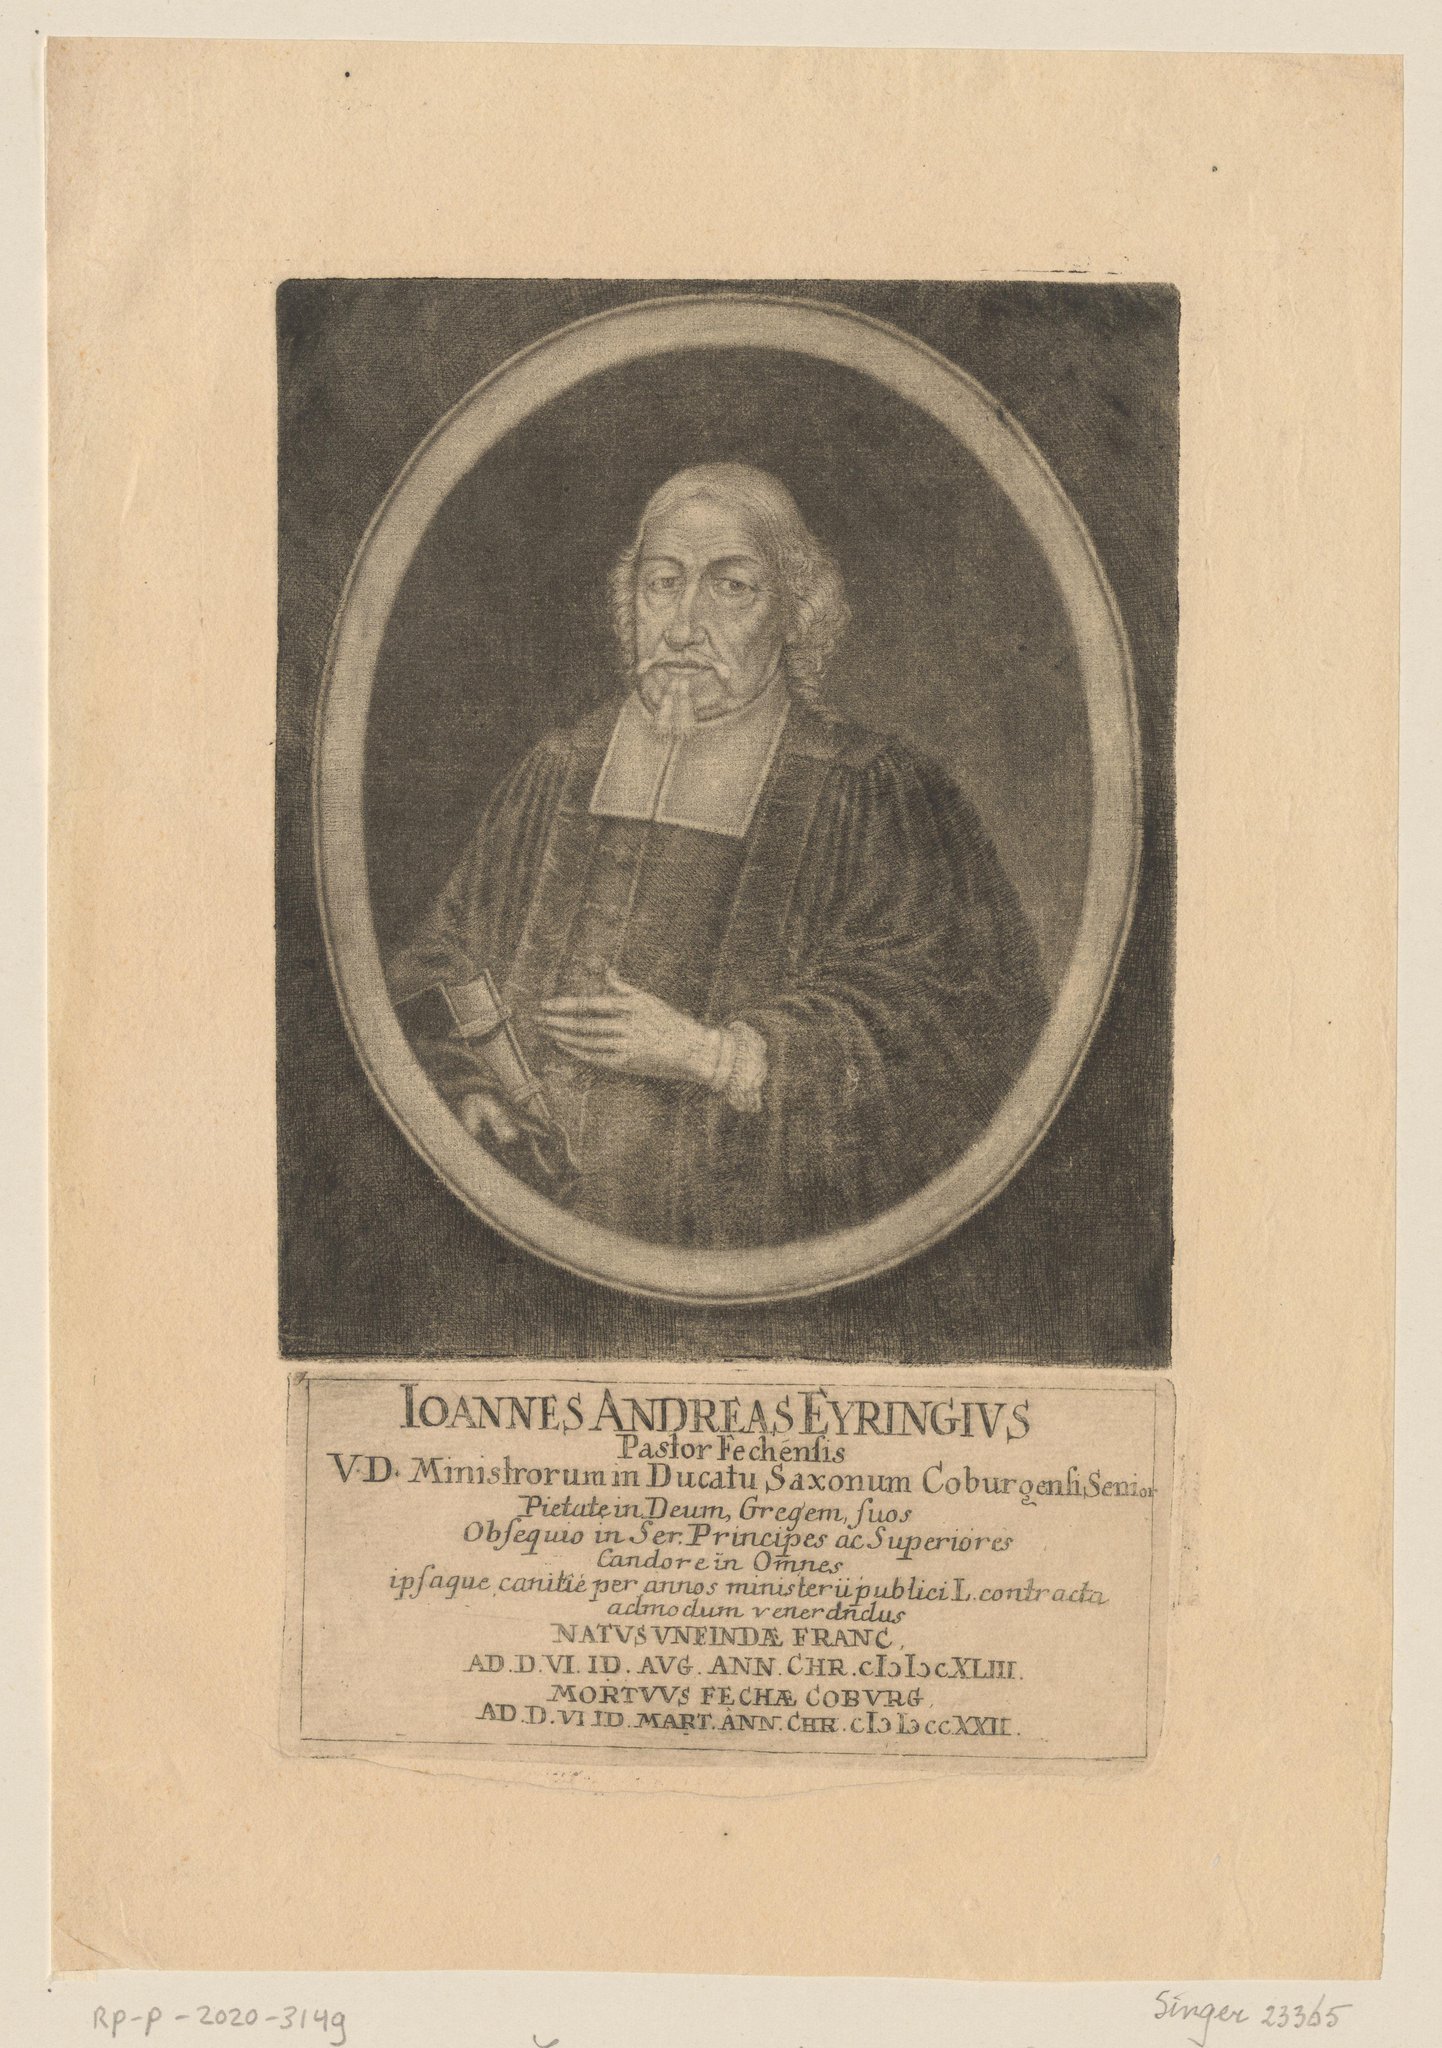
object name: print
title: Portret van Johann Andreas Eyring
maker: Anonymous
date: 1722-1750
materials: paper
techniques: engraving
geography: germany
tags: historical persons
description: Met onderschrift in het Latijn, gedrukt van een aparte plaat.